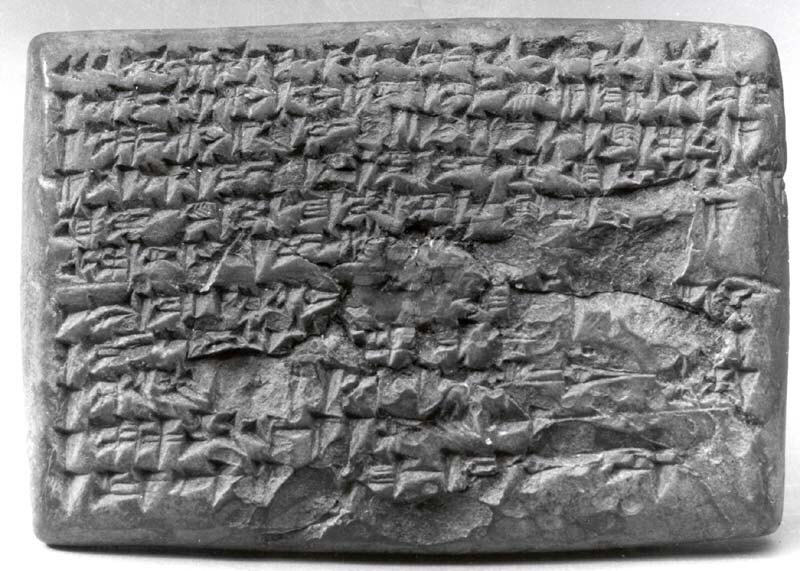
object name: cuneiform tablet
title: Cuneiform tablet: promissory note for silver, Ebabbar archive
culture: assyrian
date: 626 BCE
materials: clay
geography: mesopotamia